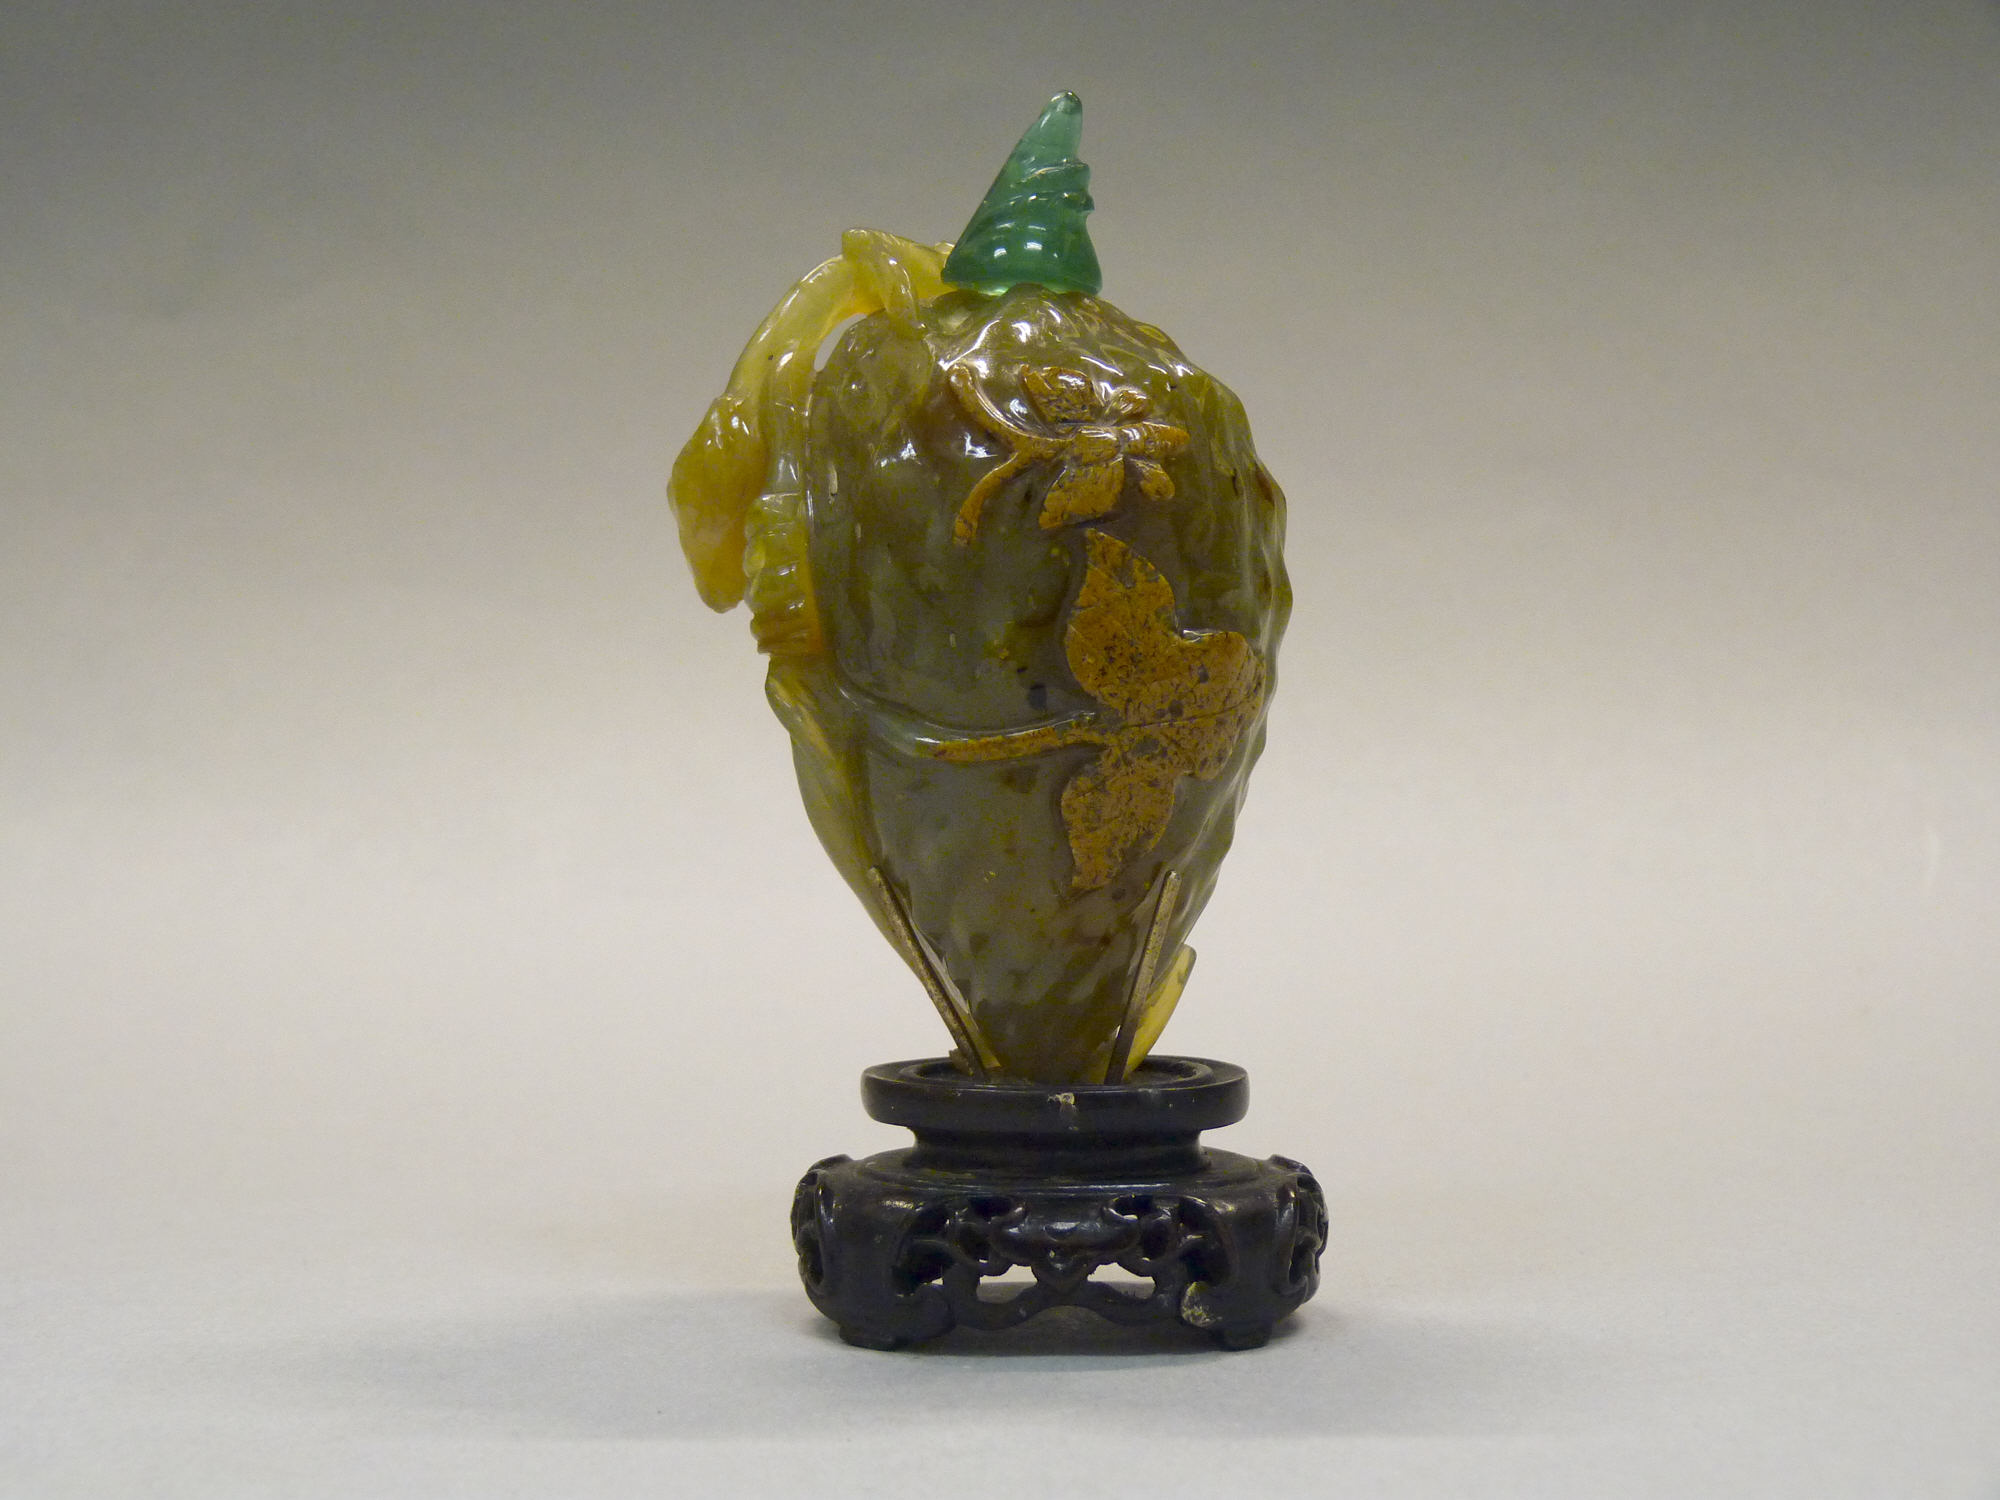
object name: snuff bottle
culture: chinese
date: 1736-1795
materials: stone, glass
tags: butterflies